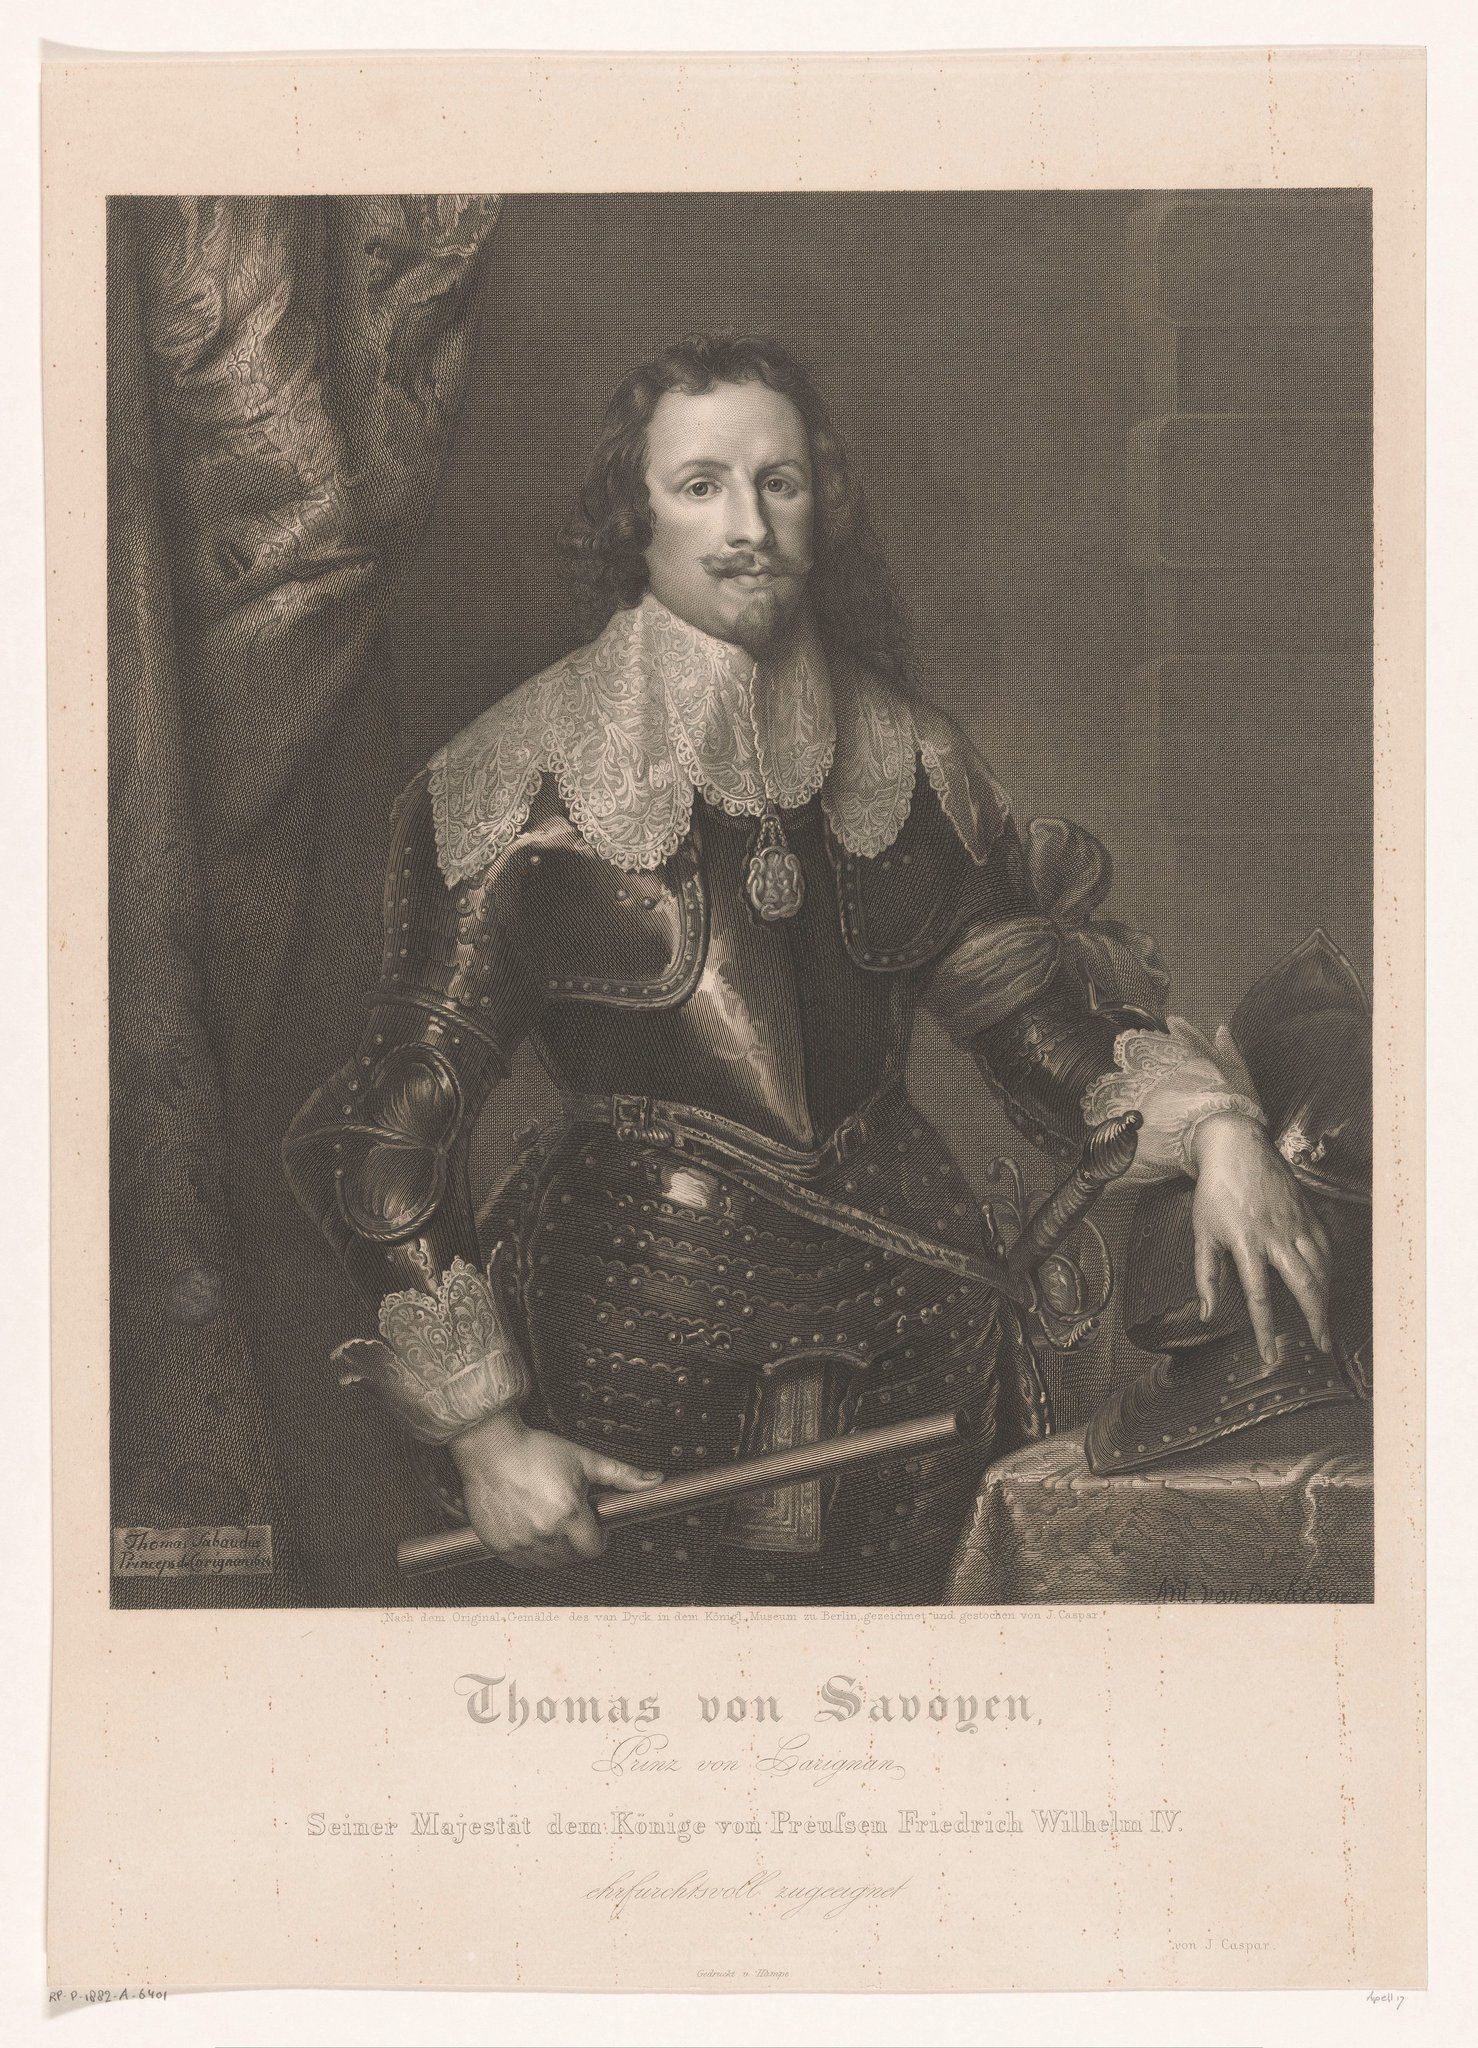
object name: print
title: Portret van Francesco Tommaso van Savoye, prins van Carignano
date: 1840-1861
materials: paper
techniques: engraving, etching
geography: berlin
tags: armour, historical persons, baton of general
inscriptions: collector's mark: Lugt 2228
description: Naar het schilderij van Anthony van Dyck in de Gemäldegalerie der Staatlichen Museen zu Berlin, inv. nr. 782.